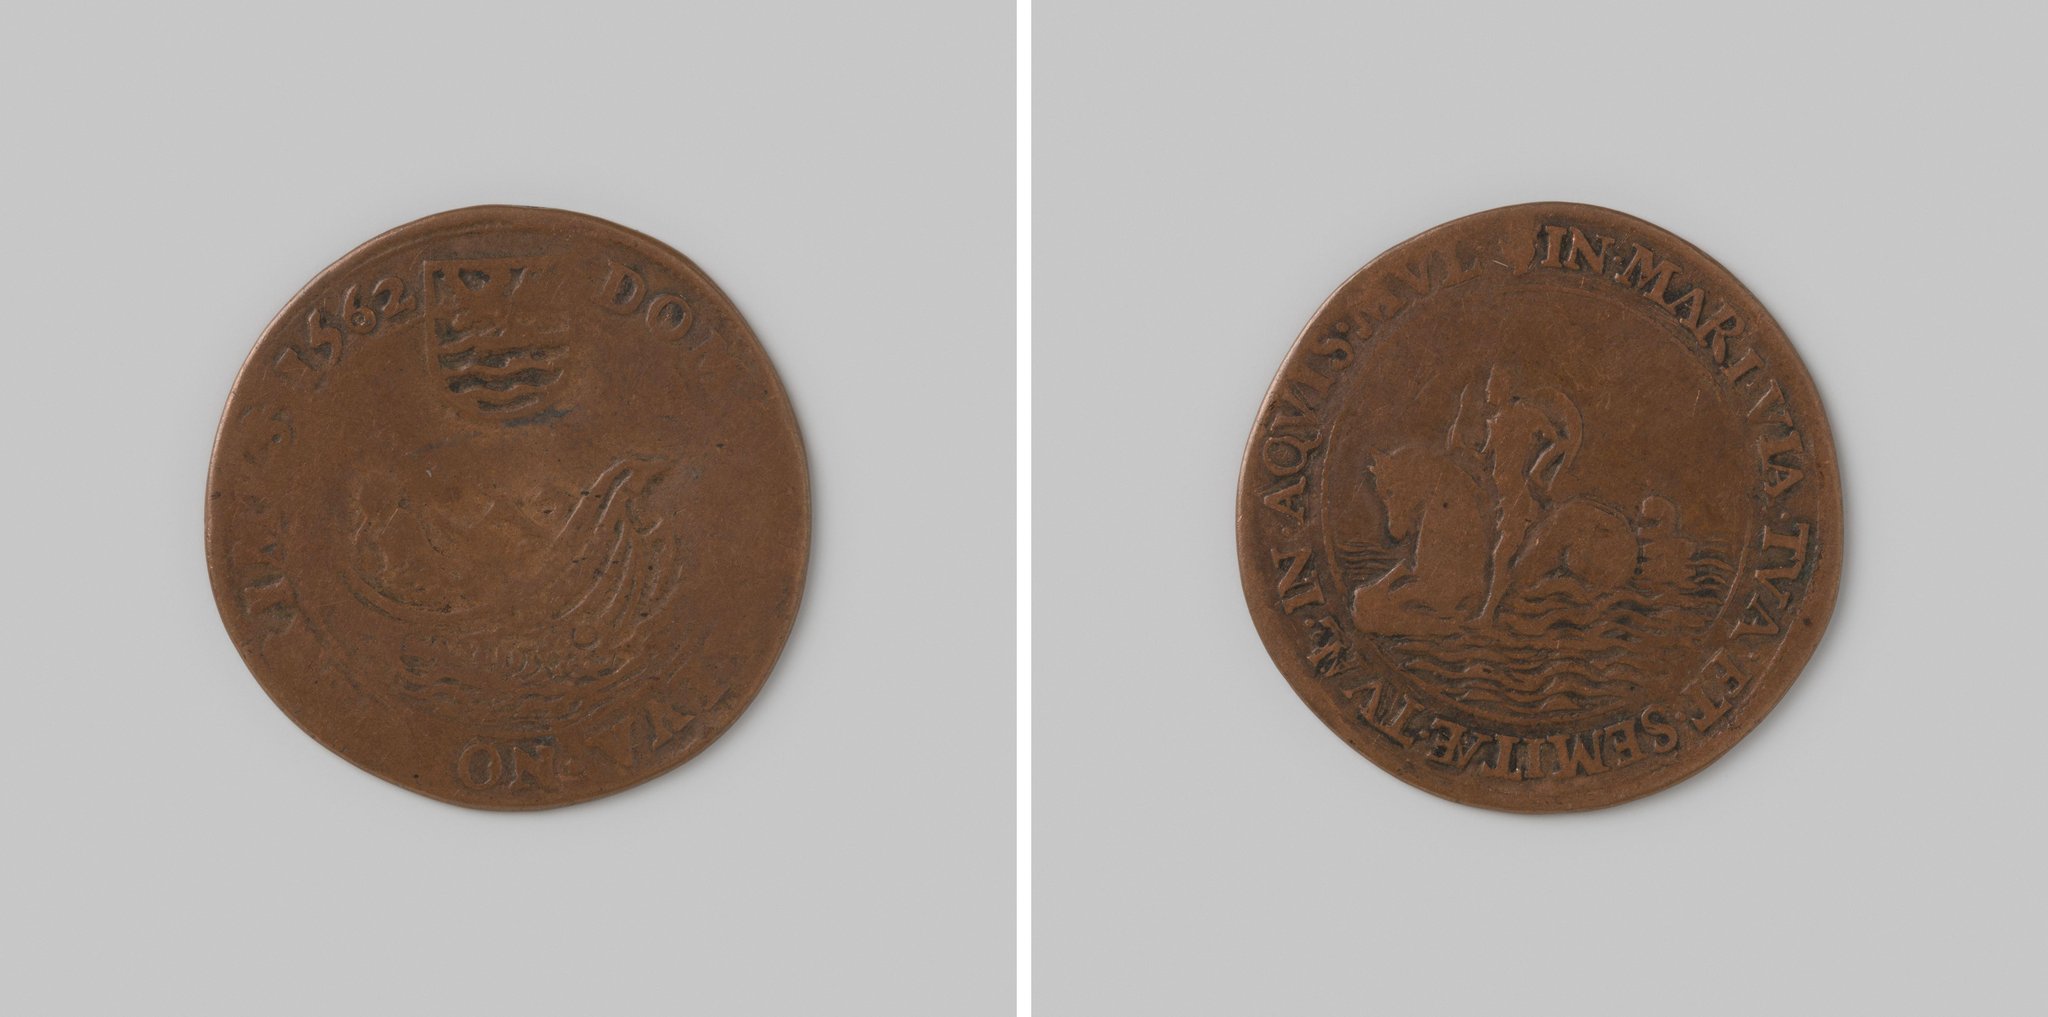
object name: history medal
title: Rekenpenning uit Antwerpen voor Zeeland 1562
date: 1562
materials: copper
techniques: striking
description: Koperen penning, op de voorzijde een schip in nood waarop Christus gewekt wordt, onder het wapenschild van Zeeland, met omschrift, op de keerzijde de Koning op een hippocampus naar links, met omschrift.